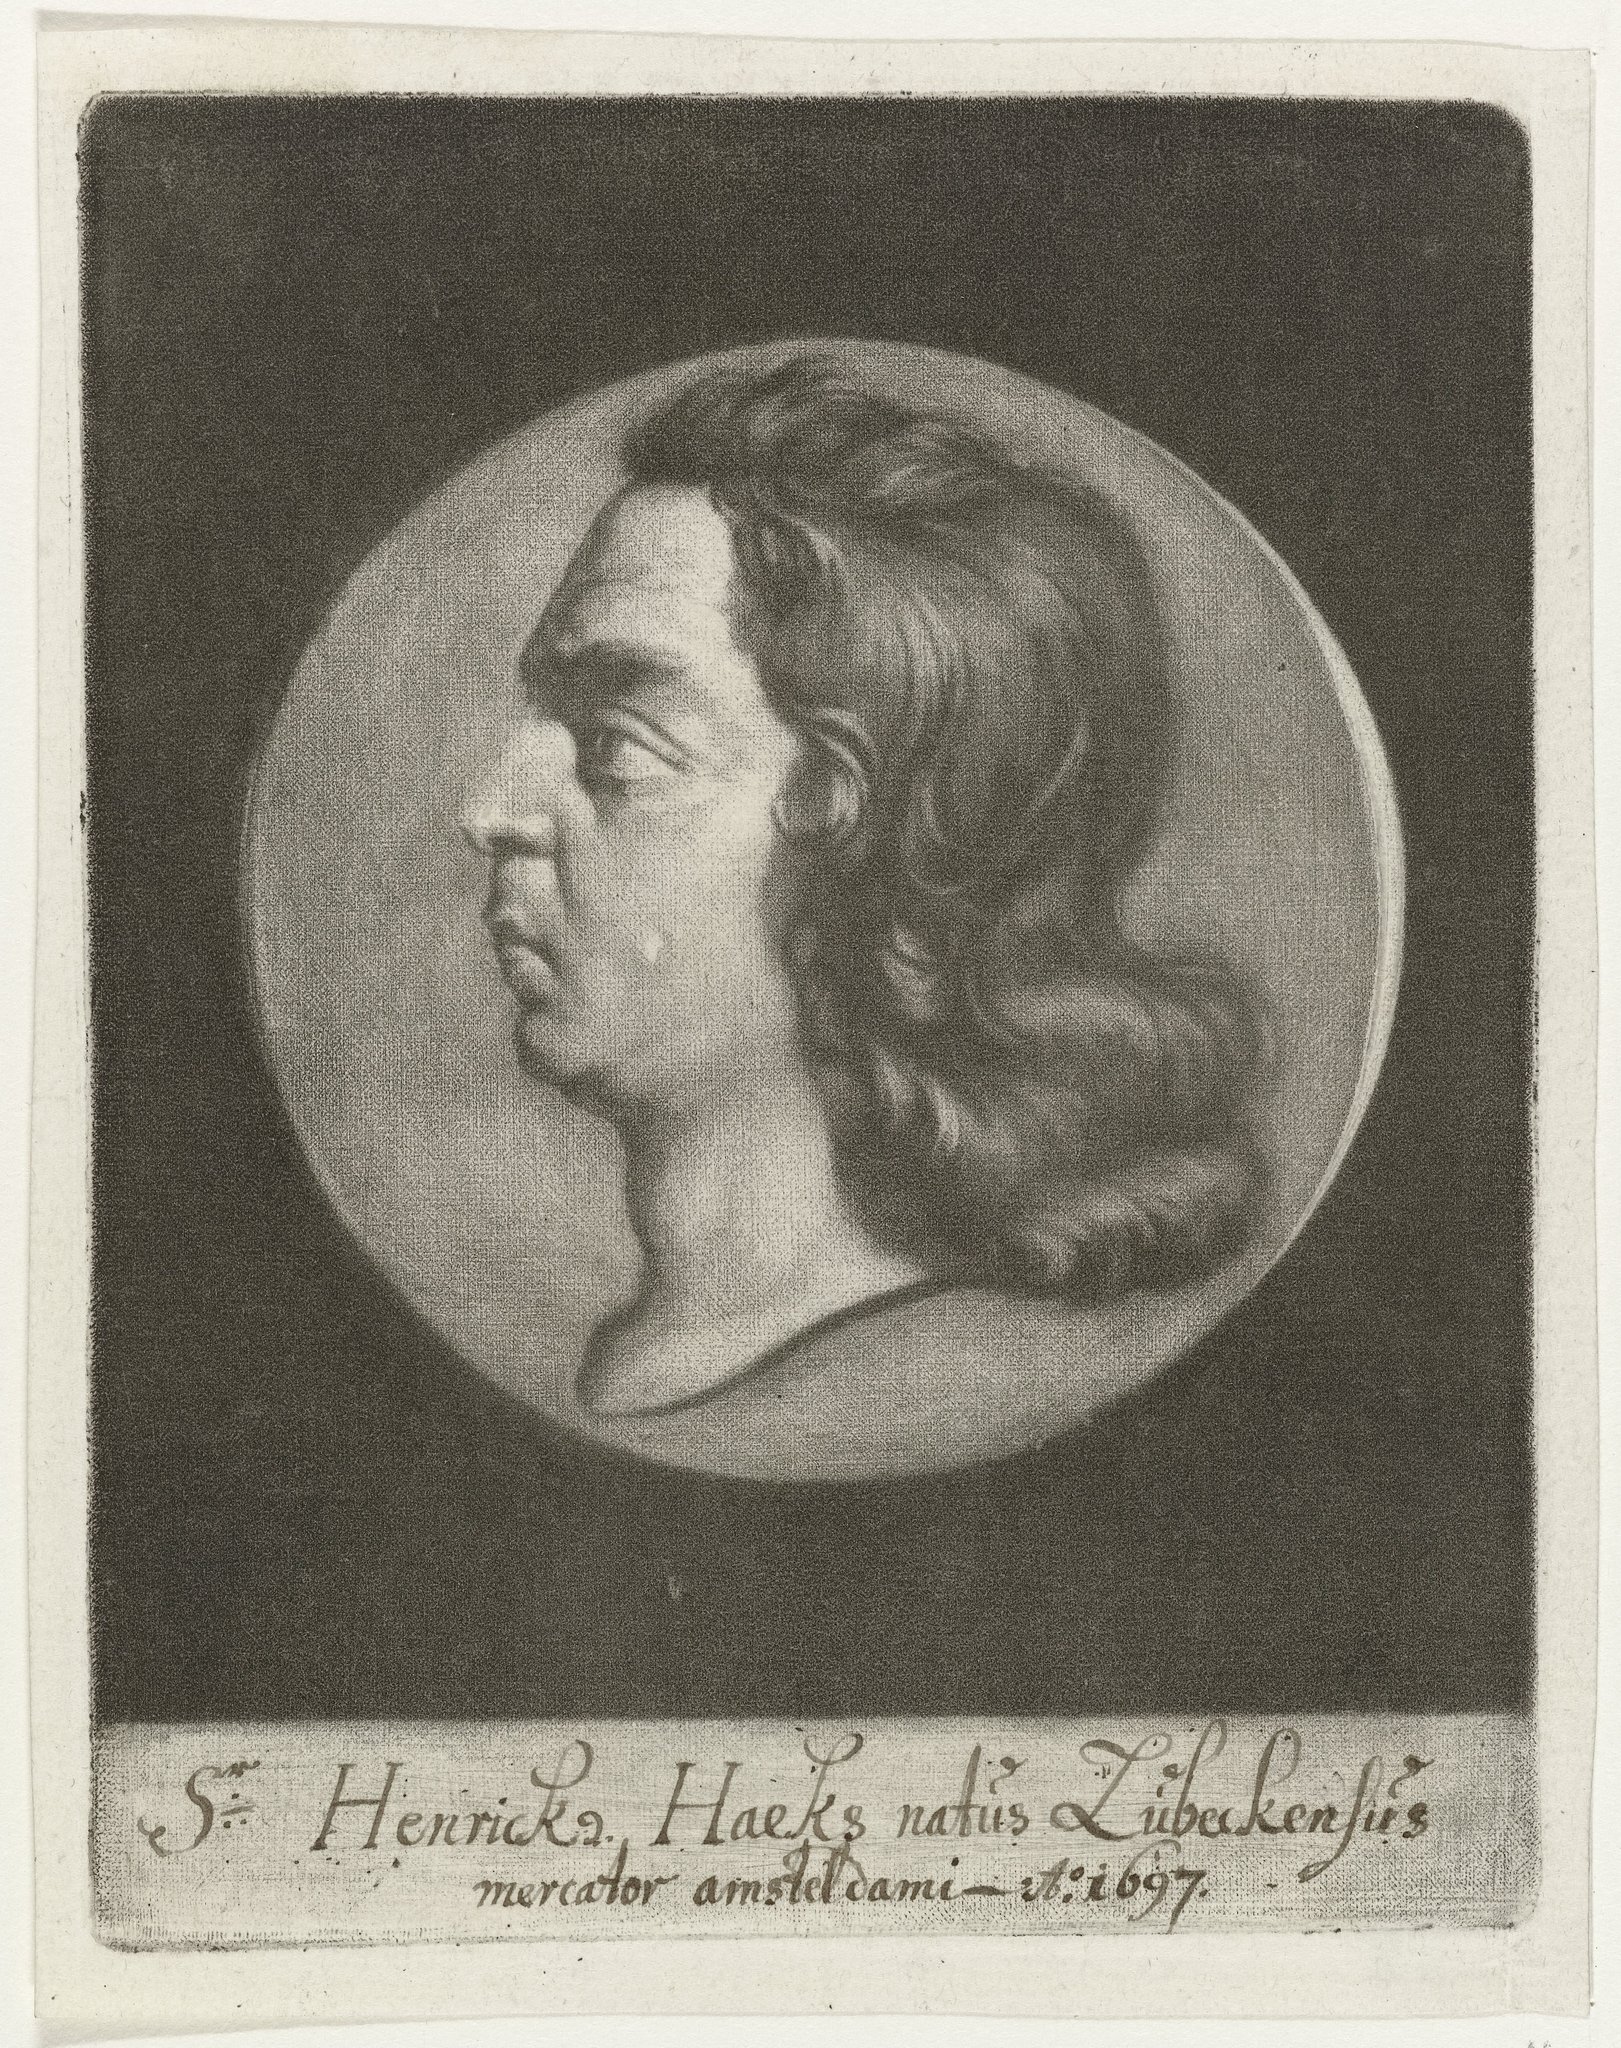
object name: print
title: Portret van Hendricks Haecks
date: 1683-1746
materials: paper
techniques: mezzotint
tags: koopman, haecks, henricksz.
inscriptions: collector's mark: Lugt 240, inscription: ‘Sr. Hendricks. Heaks natus Lutbeckensus mercator amsteldami AO. 1697’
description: De Duitse koopman Hendricks Haecks, in profiel.